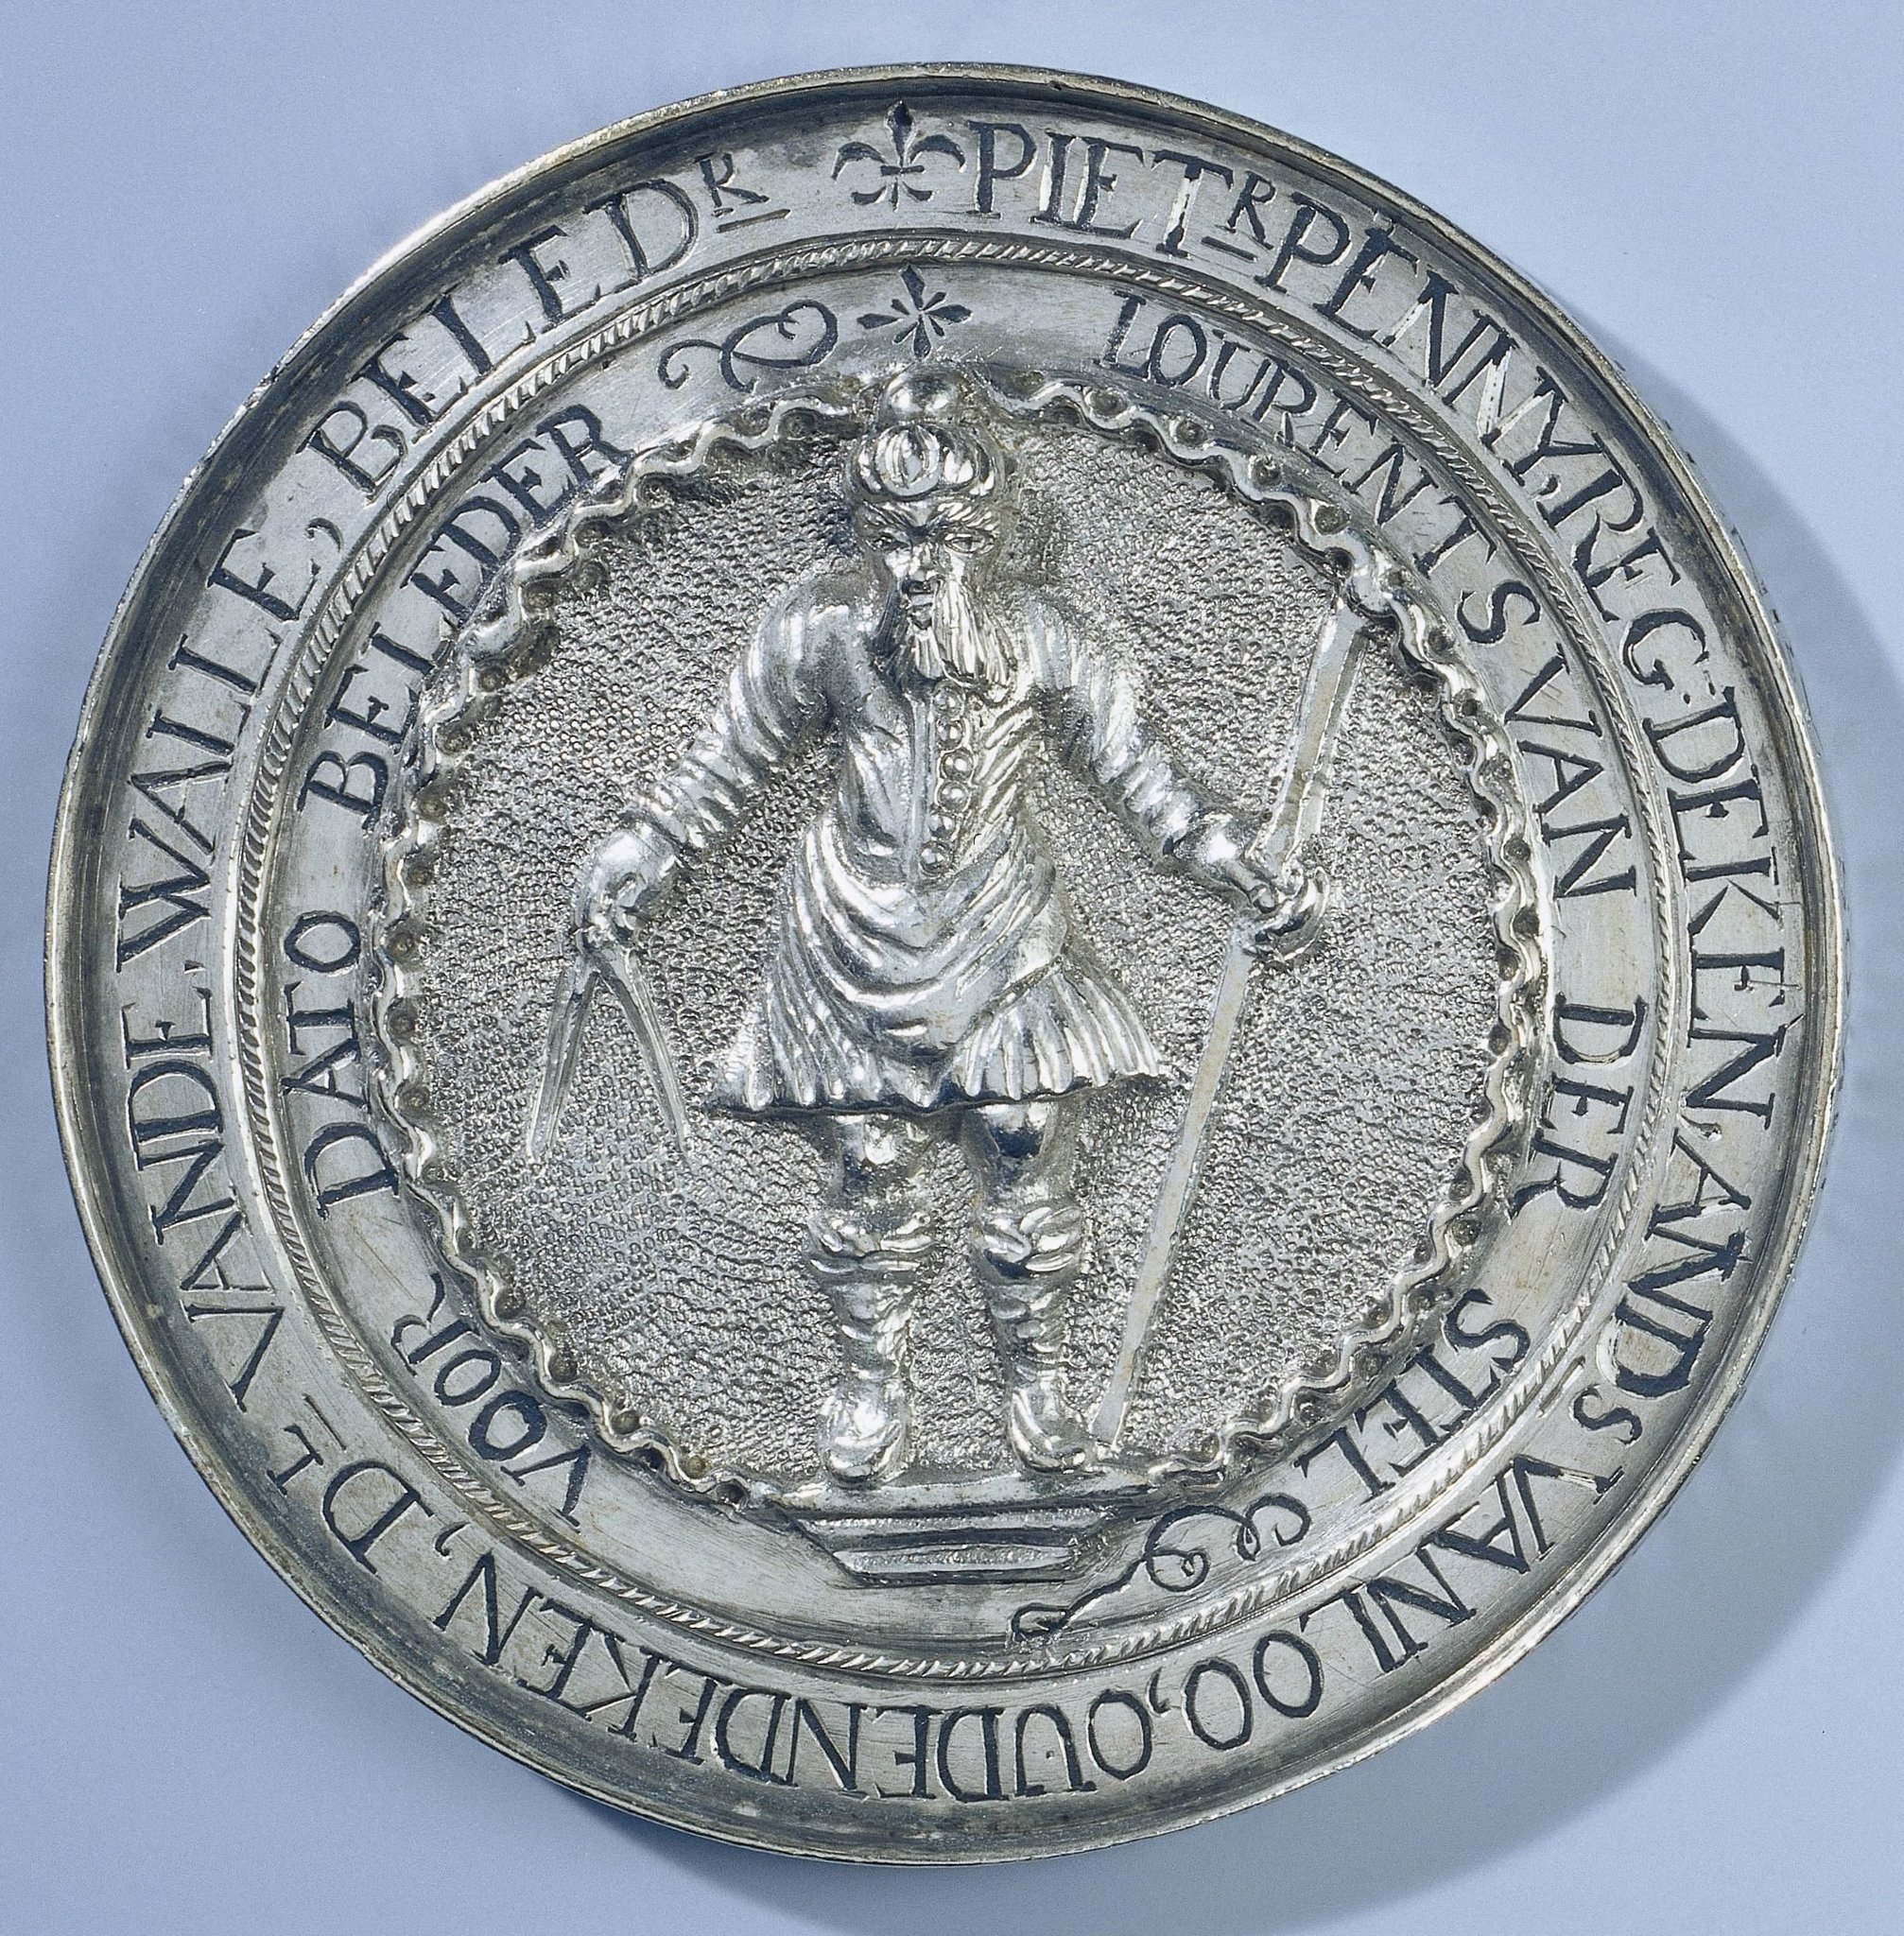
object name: medal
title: Timmerliedengilde van Rotterdam, gildepenning met no. 103 en no. 9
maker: Anonymous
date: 1600-1700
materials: brass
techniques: casting, engraving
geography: rotterdam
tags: rotterdam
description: Guilds were urban organisations of people in specific occupations. The guild represented the interests of the profession. Each member had a token as proof of membership. The person’s name was engraved on one side of the token, often together with the arms of the guild or of the city in which it was based. The other side carried a motif signifying the occupation represented by the guild.